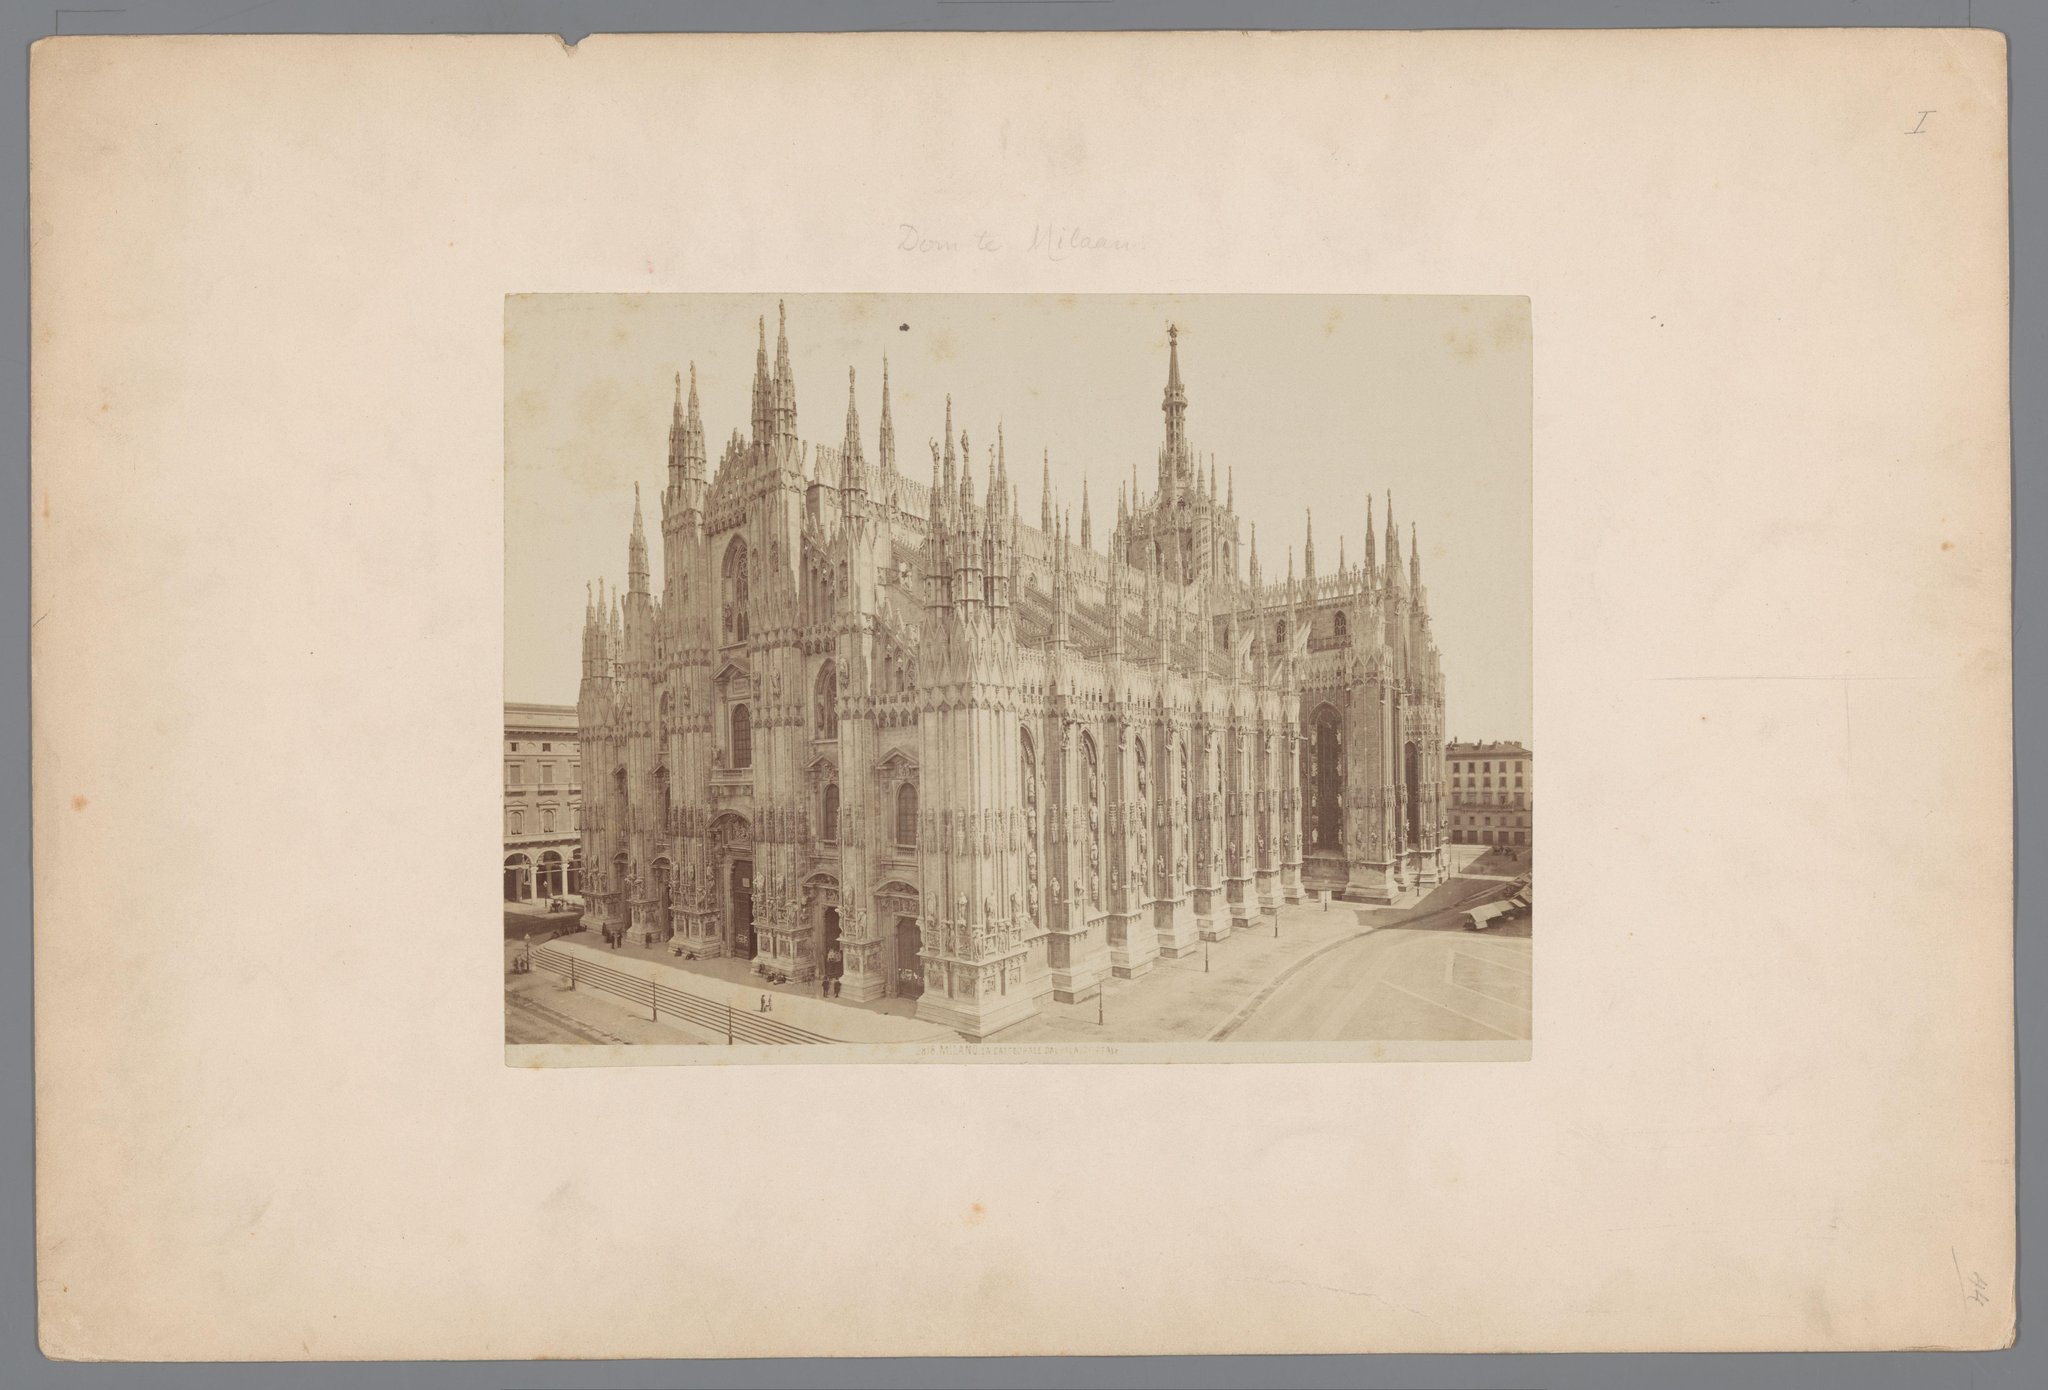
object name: photograph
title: MILANO. LA CATTEDRALE DAL PALAZZO REALE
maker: Anonymous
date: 1875-1900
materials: cardboard, photographic support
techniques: albumen print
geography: milan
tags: church (exterior)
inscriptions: collector's mark: Lugt 3937, number: ‘3818.’